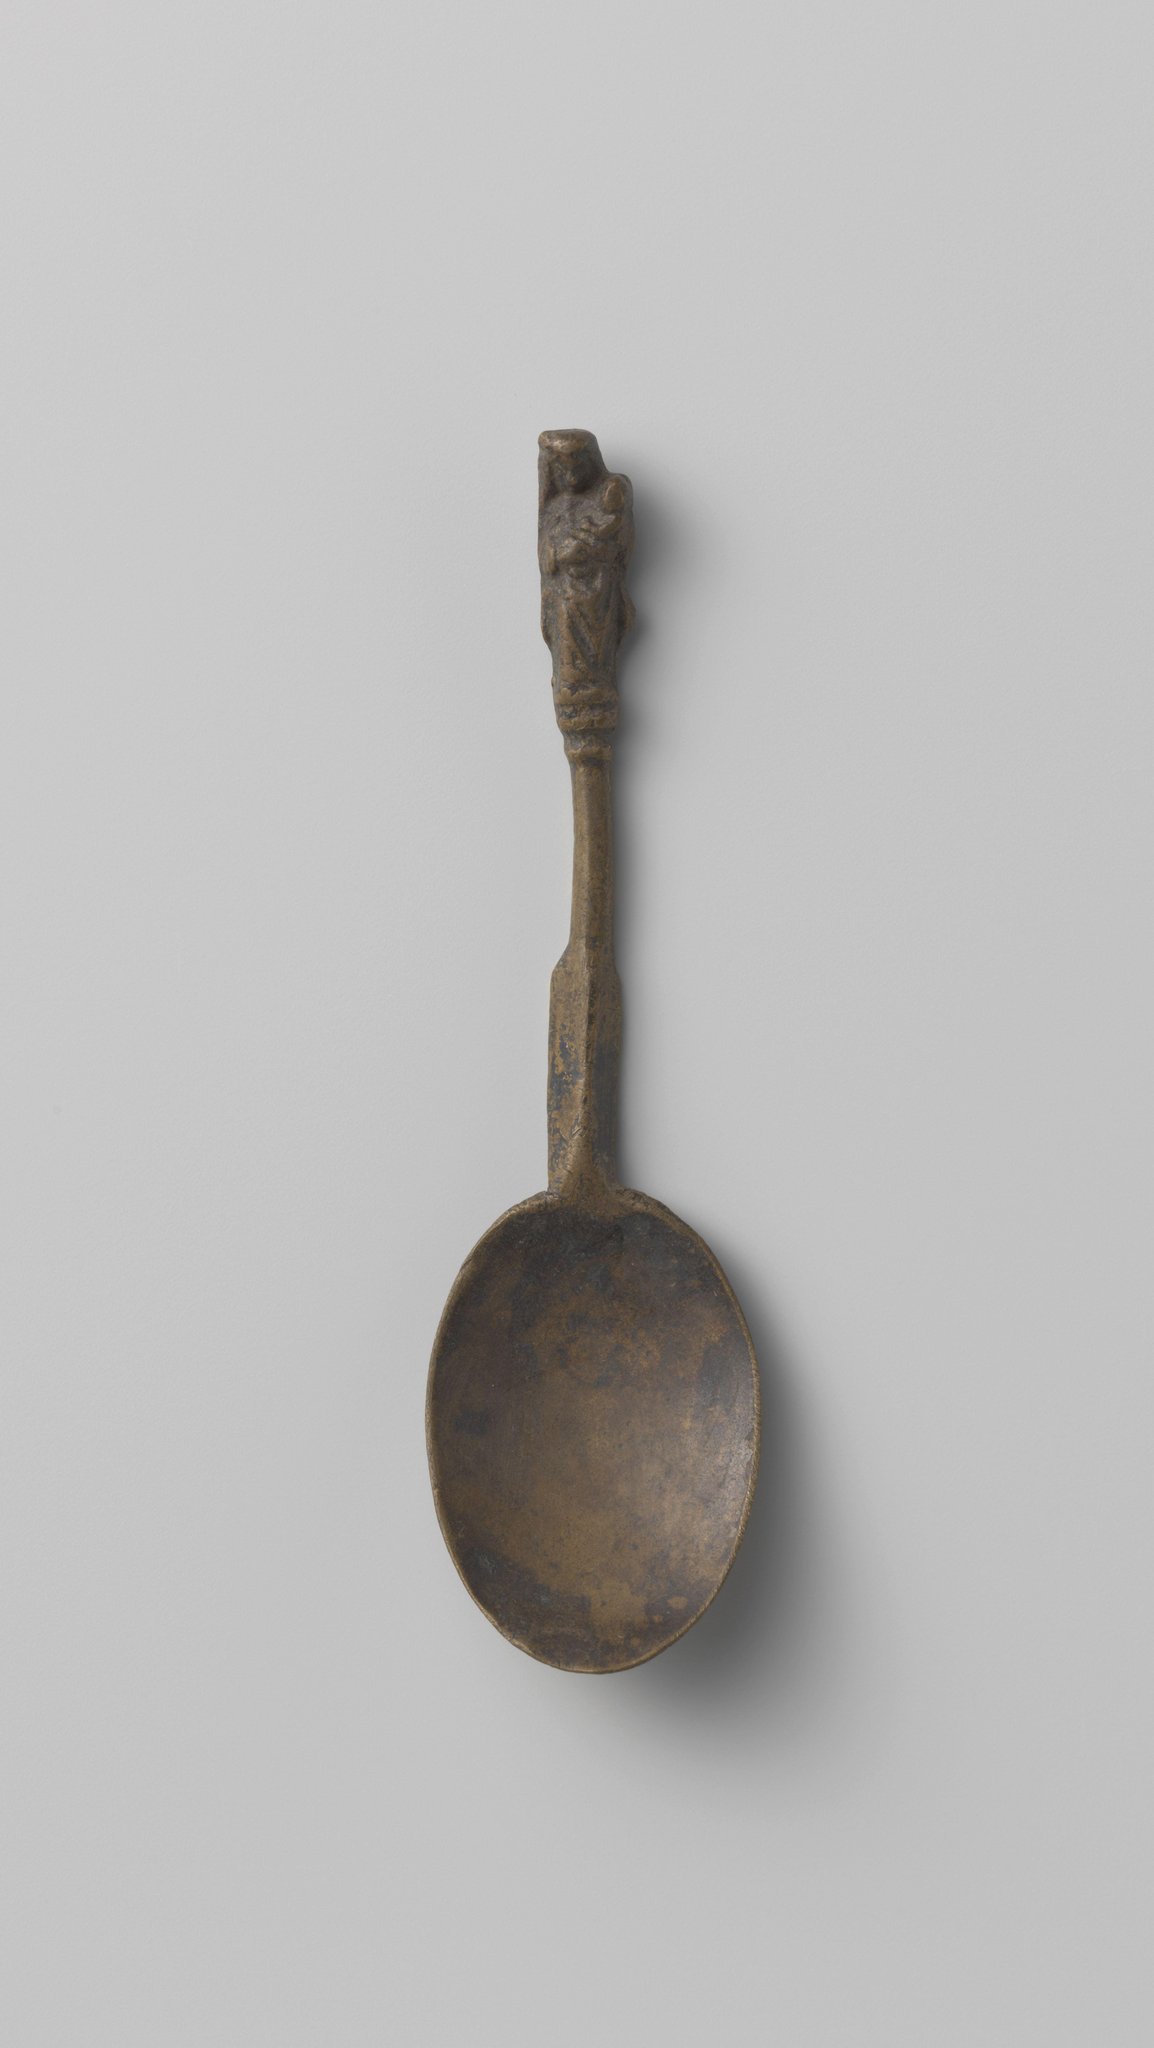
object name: spoon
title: Lepel waarvan de steel bekroond wordt door een Maria met Kind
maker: Anonymous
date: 1400-1600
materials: brass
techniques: brazing, casting, striking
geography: western europe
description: De gegoten lepel heeft een geslagen ovale bak, een steel met een driehoekig aanzetstuk, overgaande in een pilaar, waarop Maria met Kind.